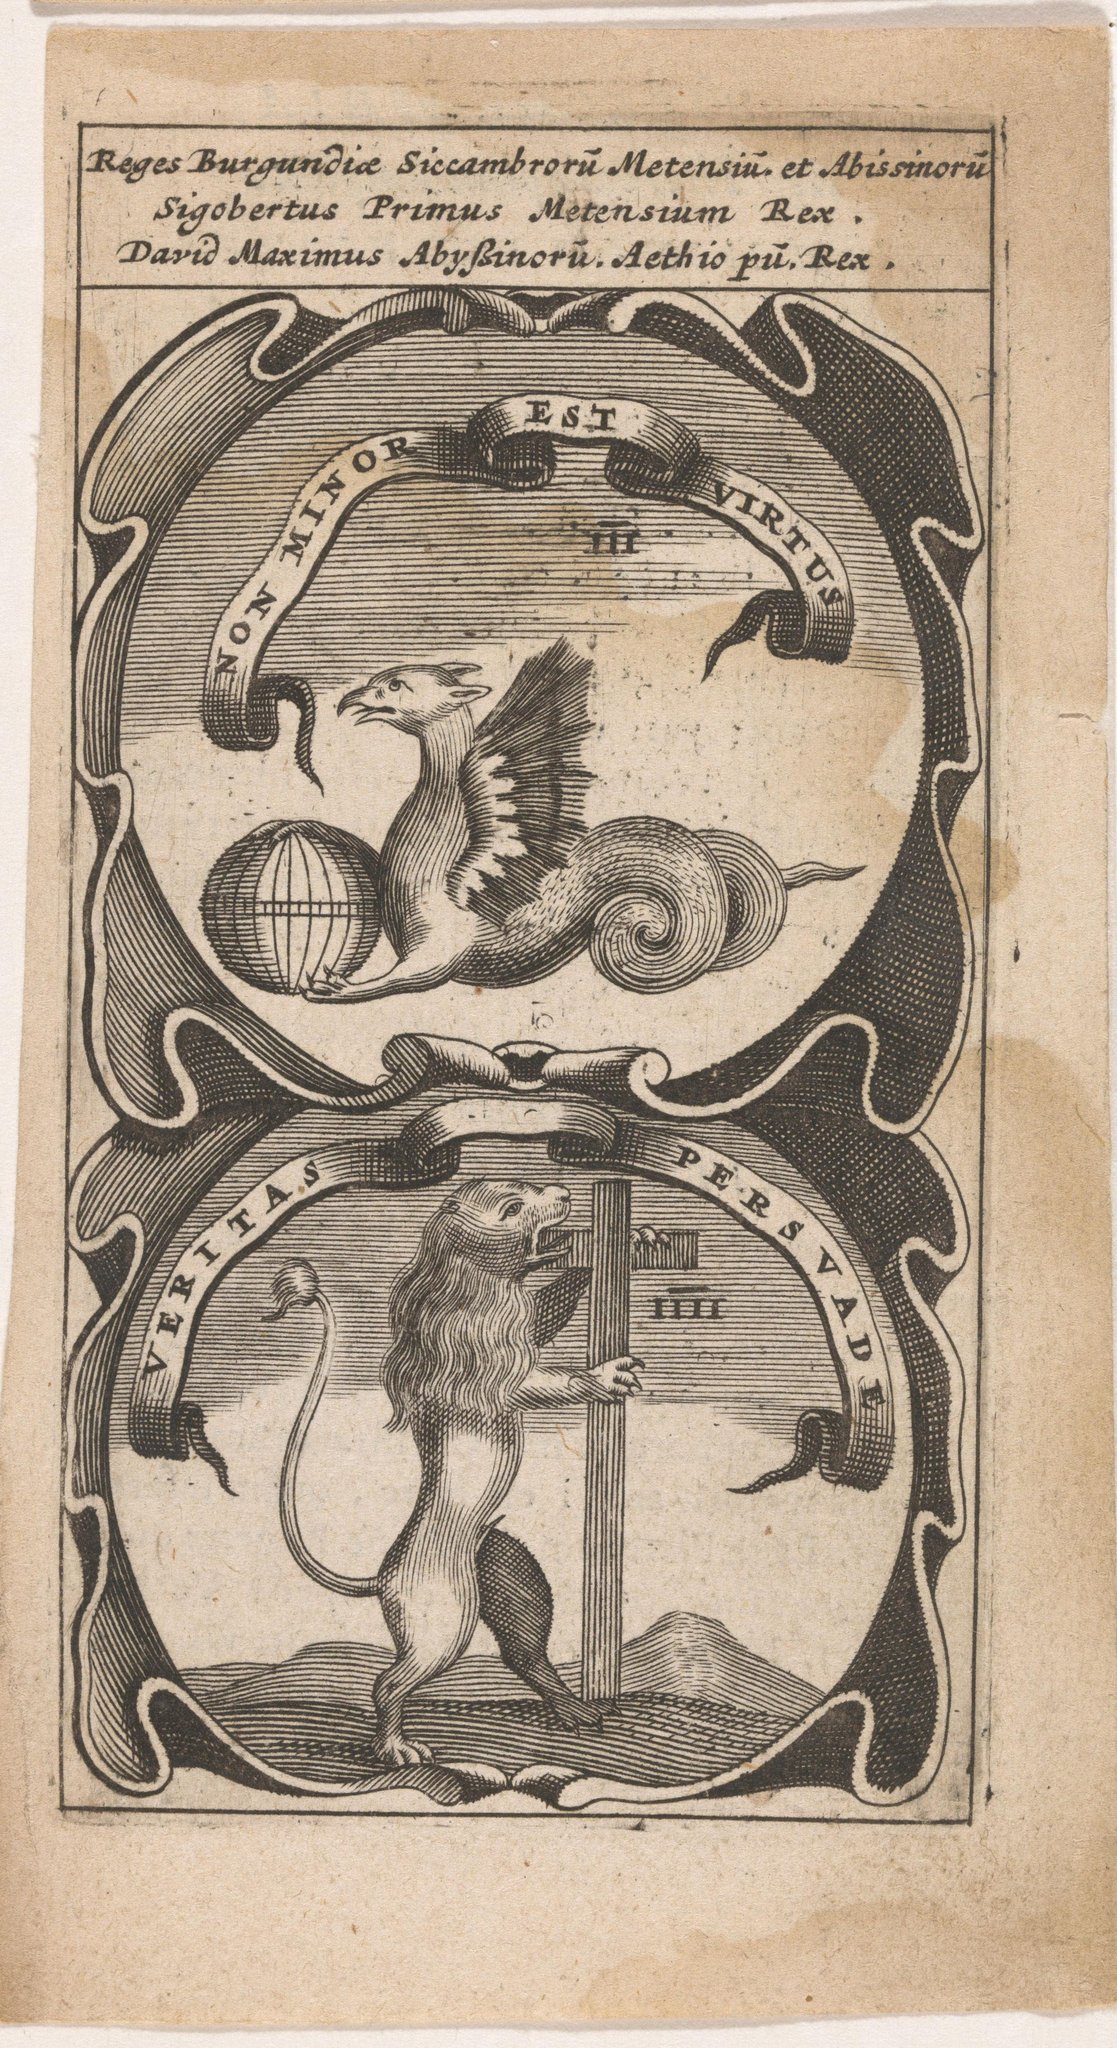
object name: print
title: Basilisk met globe / Leeuw bijtend aan een kruis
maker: Anonymous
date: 1666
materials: paper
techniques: engraving, letterpress printing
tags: globe, beasts of prey, predatory animals: lion, basilisk (cock with posterior of snake)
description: Pagina uit Jacob Typotius, Symbola Divina & Humana Pontificum Imperatorum Regum. Arnhem, J.F. Hagen, 1666 of uit de titeluitgave van 1669 of 1679. Het werk van Typotius werd voor het eerst uitgegeven in 1601 met prenten van Aegidius Sadeler.